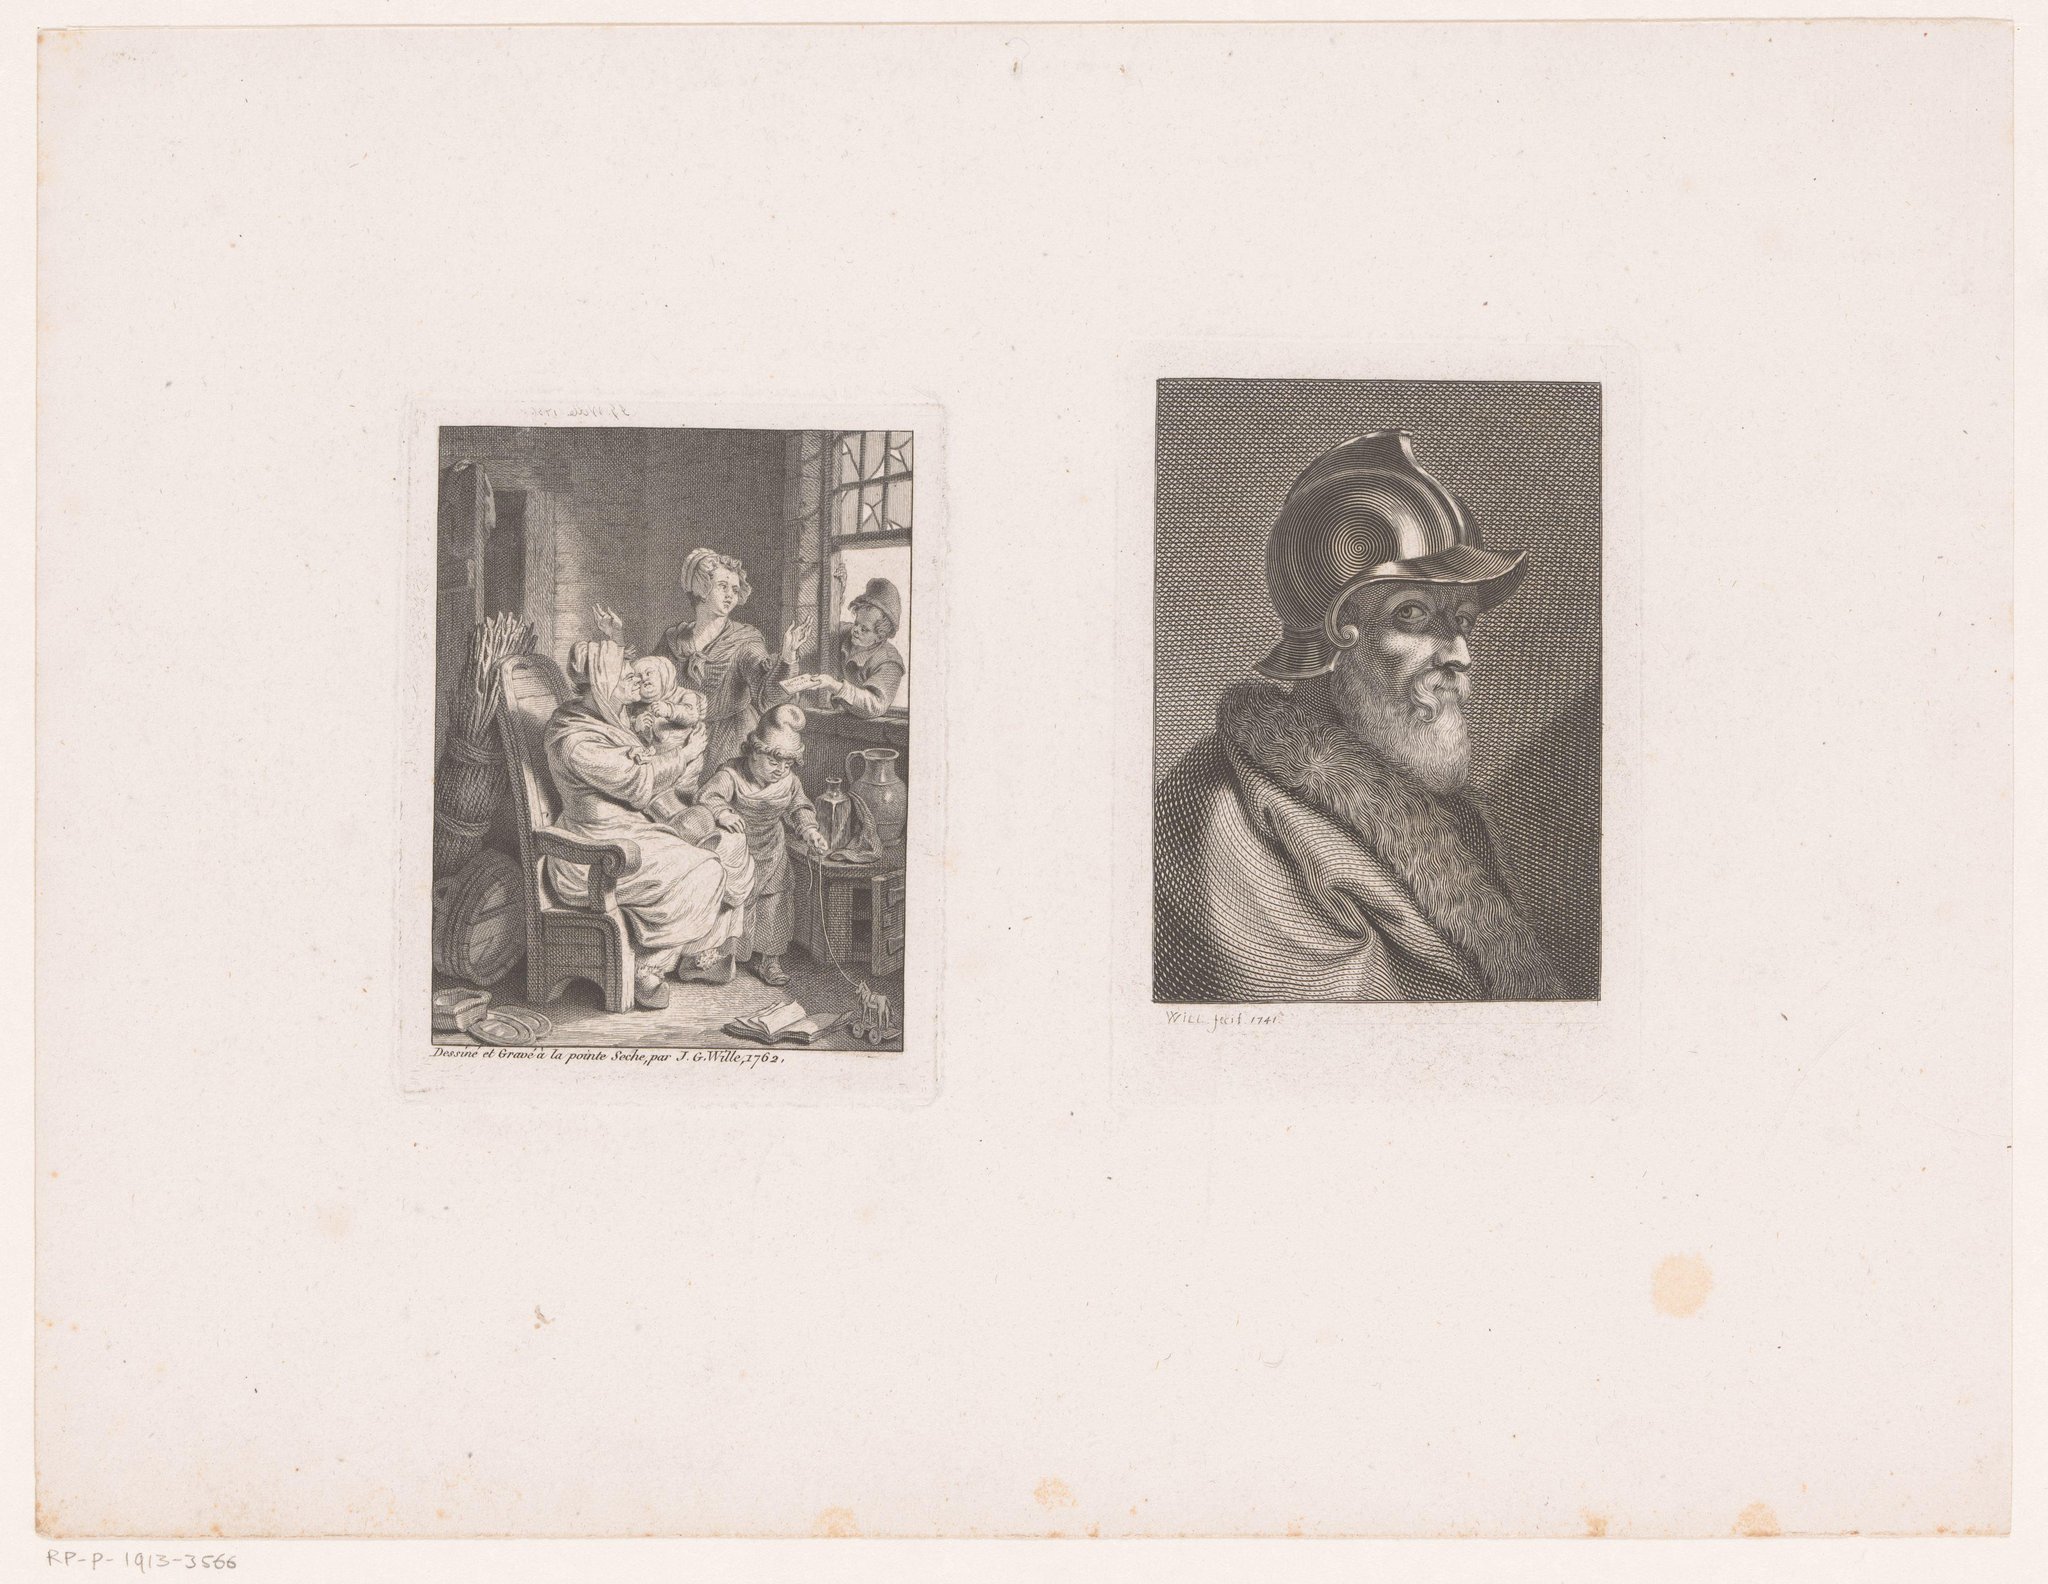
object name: print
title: Interieur met een familie en bebaarde man met helm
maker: johann georg wille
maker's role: draughtsman, print maker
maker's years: 1715-1808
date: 1741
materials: paper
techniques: engraving, etching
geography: france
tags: helmet, grandparent(s) with grandchild(ren) (family group)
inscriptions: collector's mark: Lugt 2228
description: Deze twee prenten, samen gedrukt op een niet versneden blad, maken deel uit van een serie bestaande uit een titelprent en 36 prenten met verschillende onderwerpen.